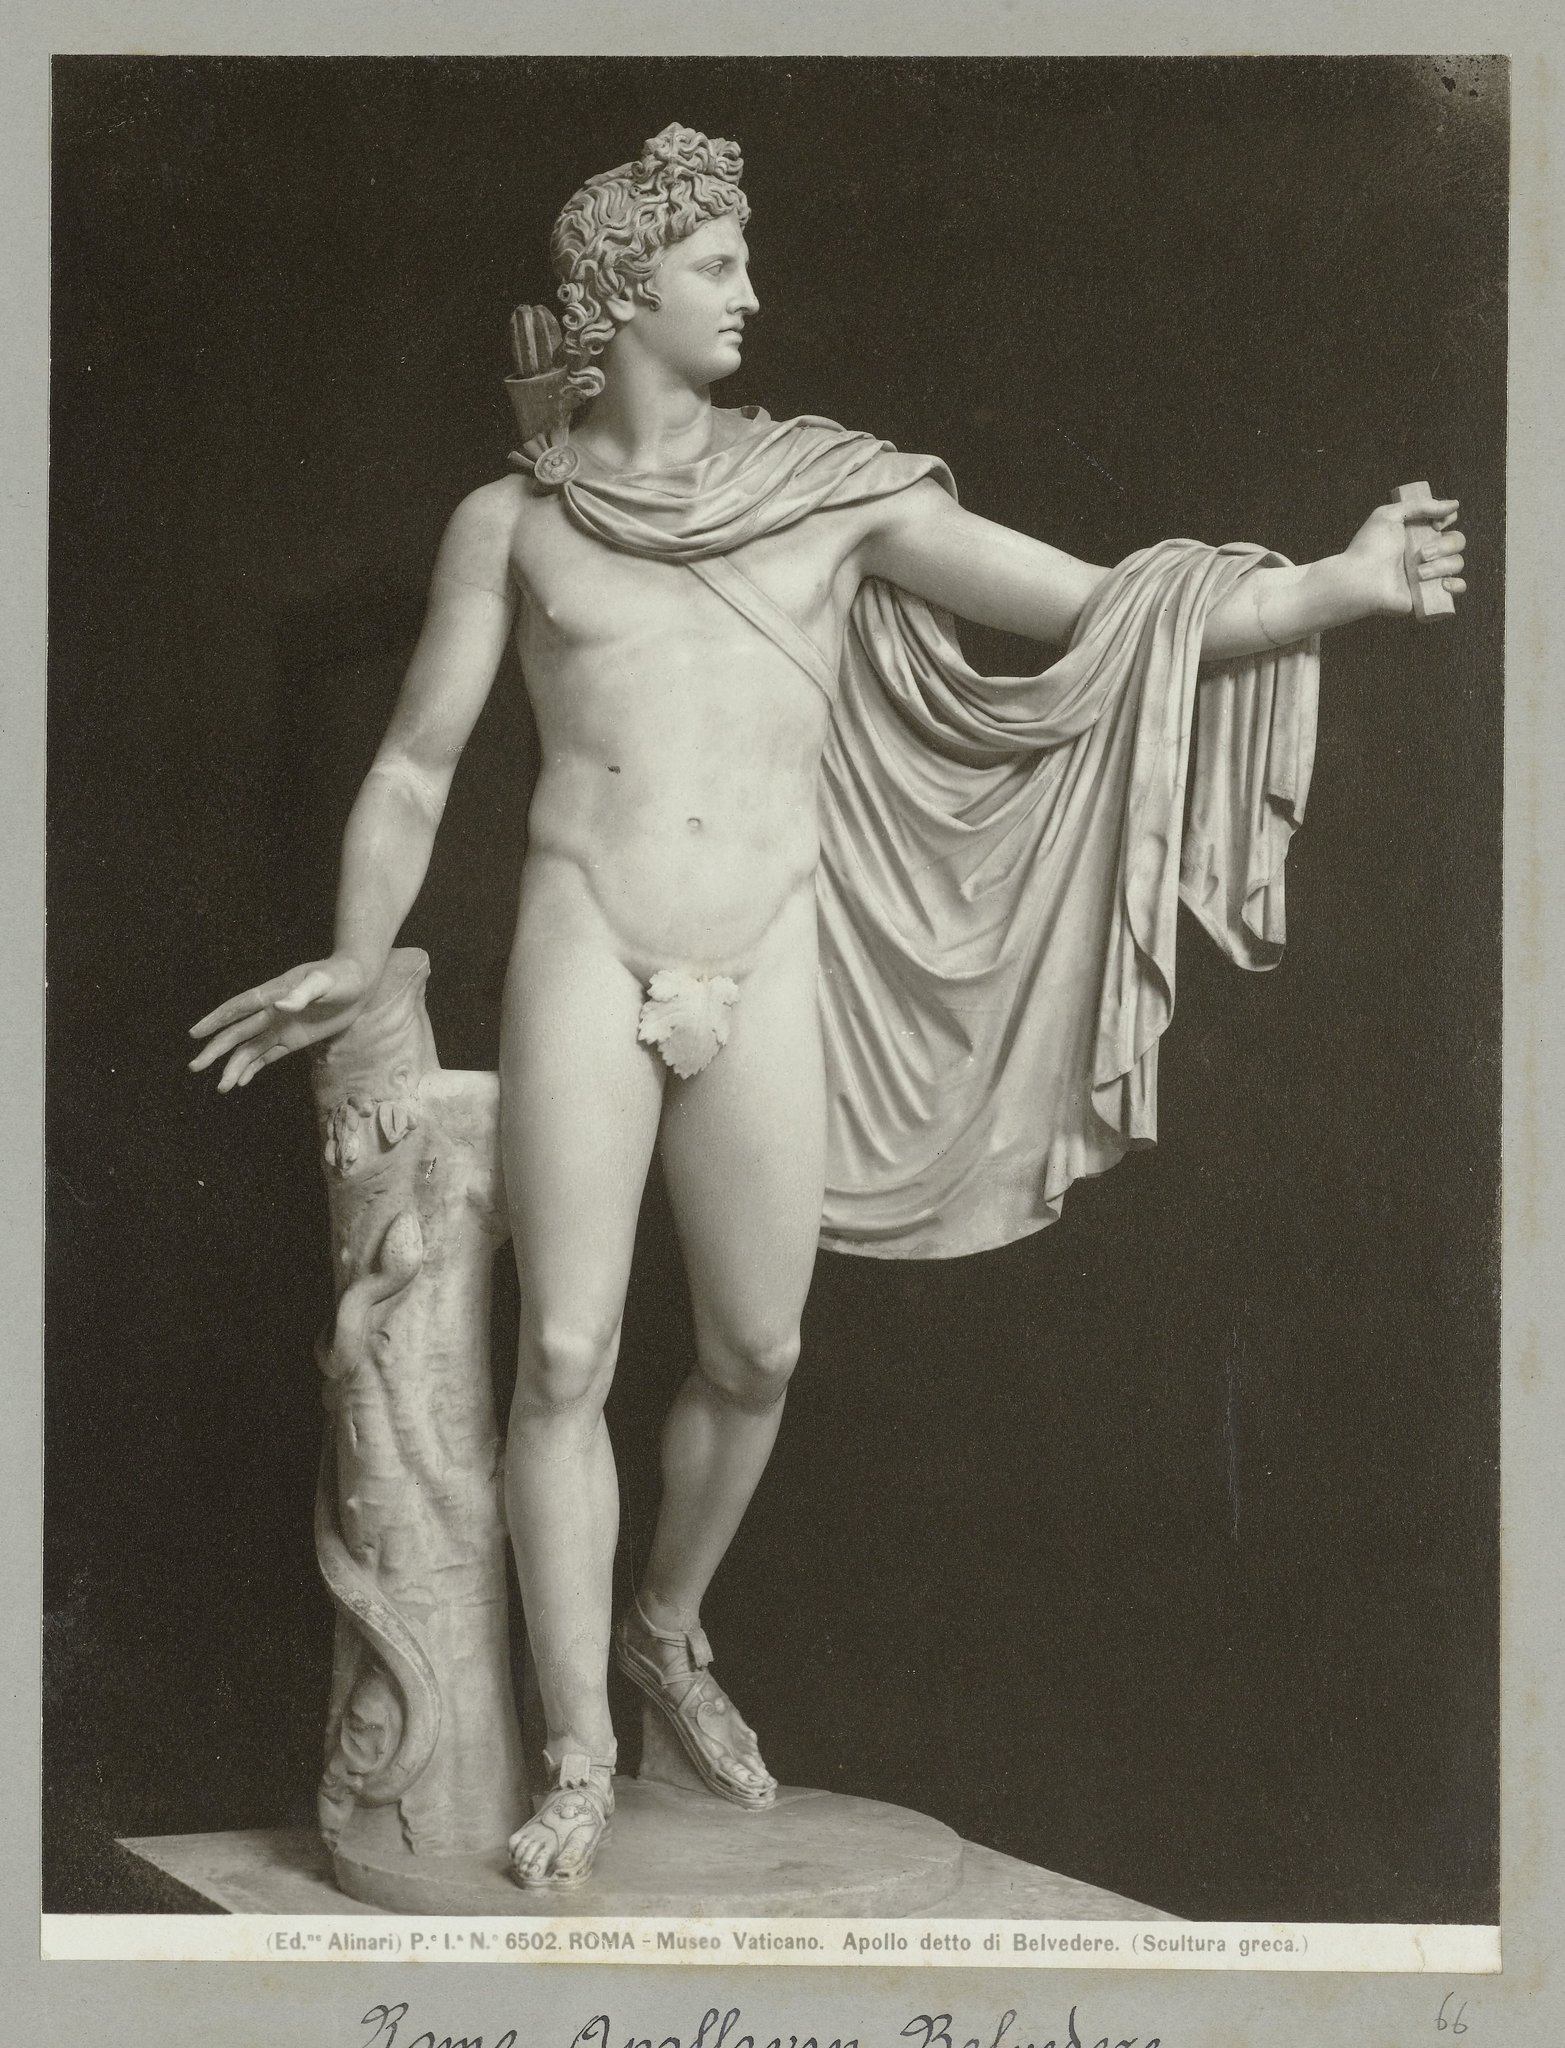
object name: photograph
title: P.I.N. 6502 Roma, museo Vaticano. Apollo detto di Belvedere (scultura Greca)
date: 1893-1903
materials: cardboard, photographic support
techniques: albumen print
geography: netherlands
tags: vaticaanse musea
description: Een marmeren beeld van Apollo Belvedere ook bekend als phyton Apollo.